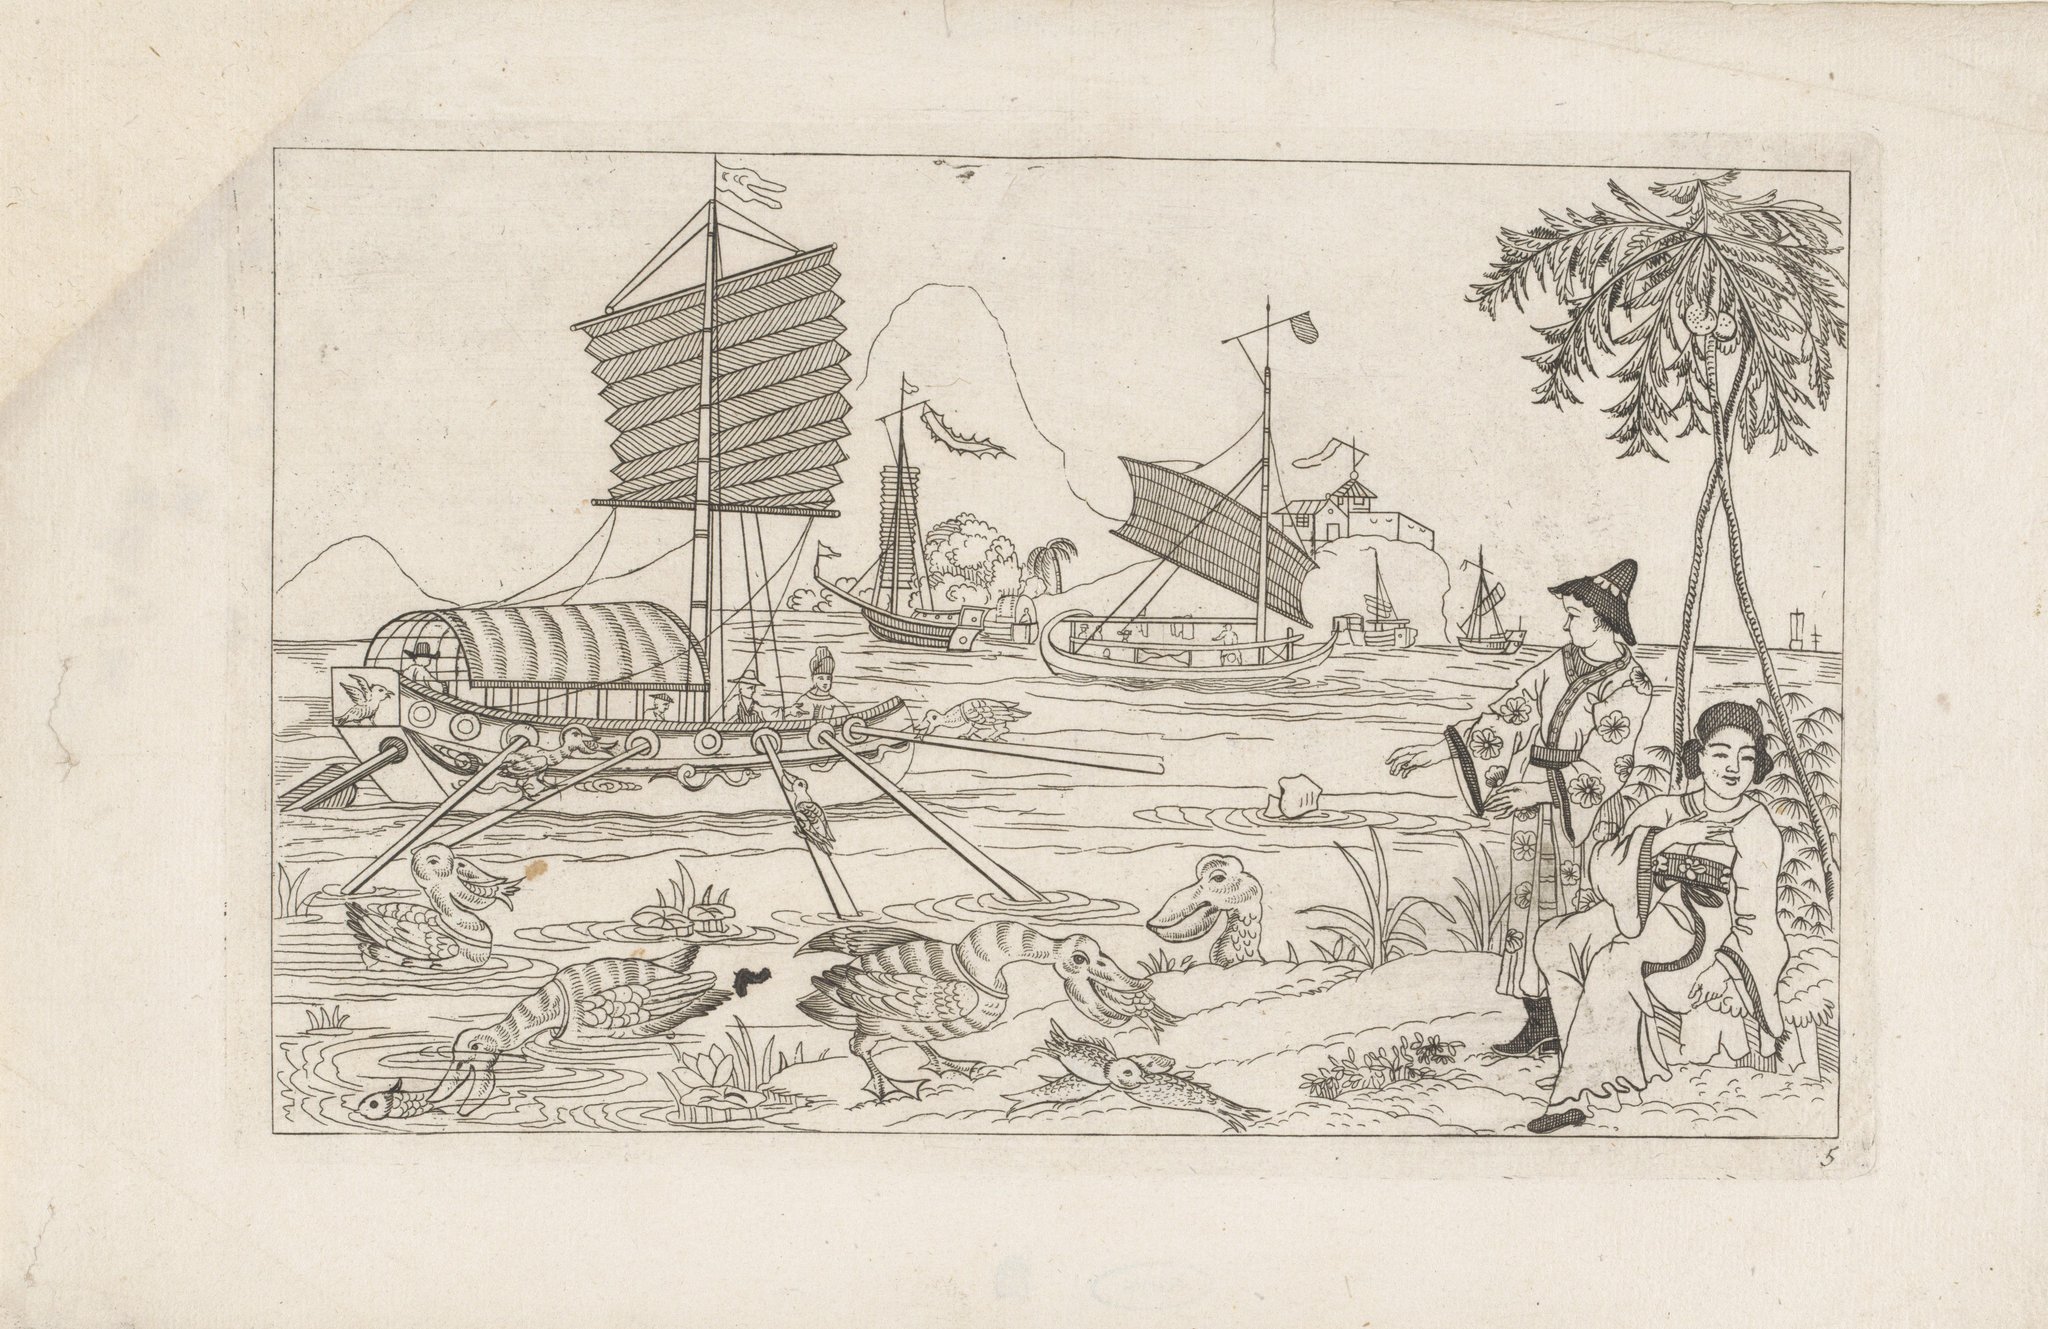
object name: print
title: Chinese Sailboats in a Bay, with Waterfowl Feeding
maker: pieter schenk (ii)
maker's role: draughtsman, print maker, publisher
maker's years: 1693-1775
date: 1715-1725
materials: paper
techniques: etching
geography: amsterdam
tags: sailing-ship, sailing-boat, chinese, water course, water-birds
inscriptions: collector's mark: Lugt 2228, collector's mark: Lugt 2760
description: A well-trained pelican regurgitates fish at the feet of an Indian fisherman. Jan van der Straet’s hunting scenes, such as the one hanging nearby, from nearly a century earlier were used as compositional models by the younger Schenk when recreating a ‘Chinese’ composition. To translate the European model into a chinoiserie print, he emphasized the linearity and eschewed shading to flatten the perspective.